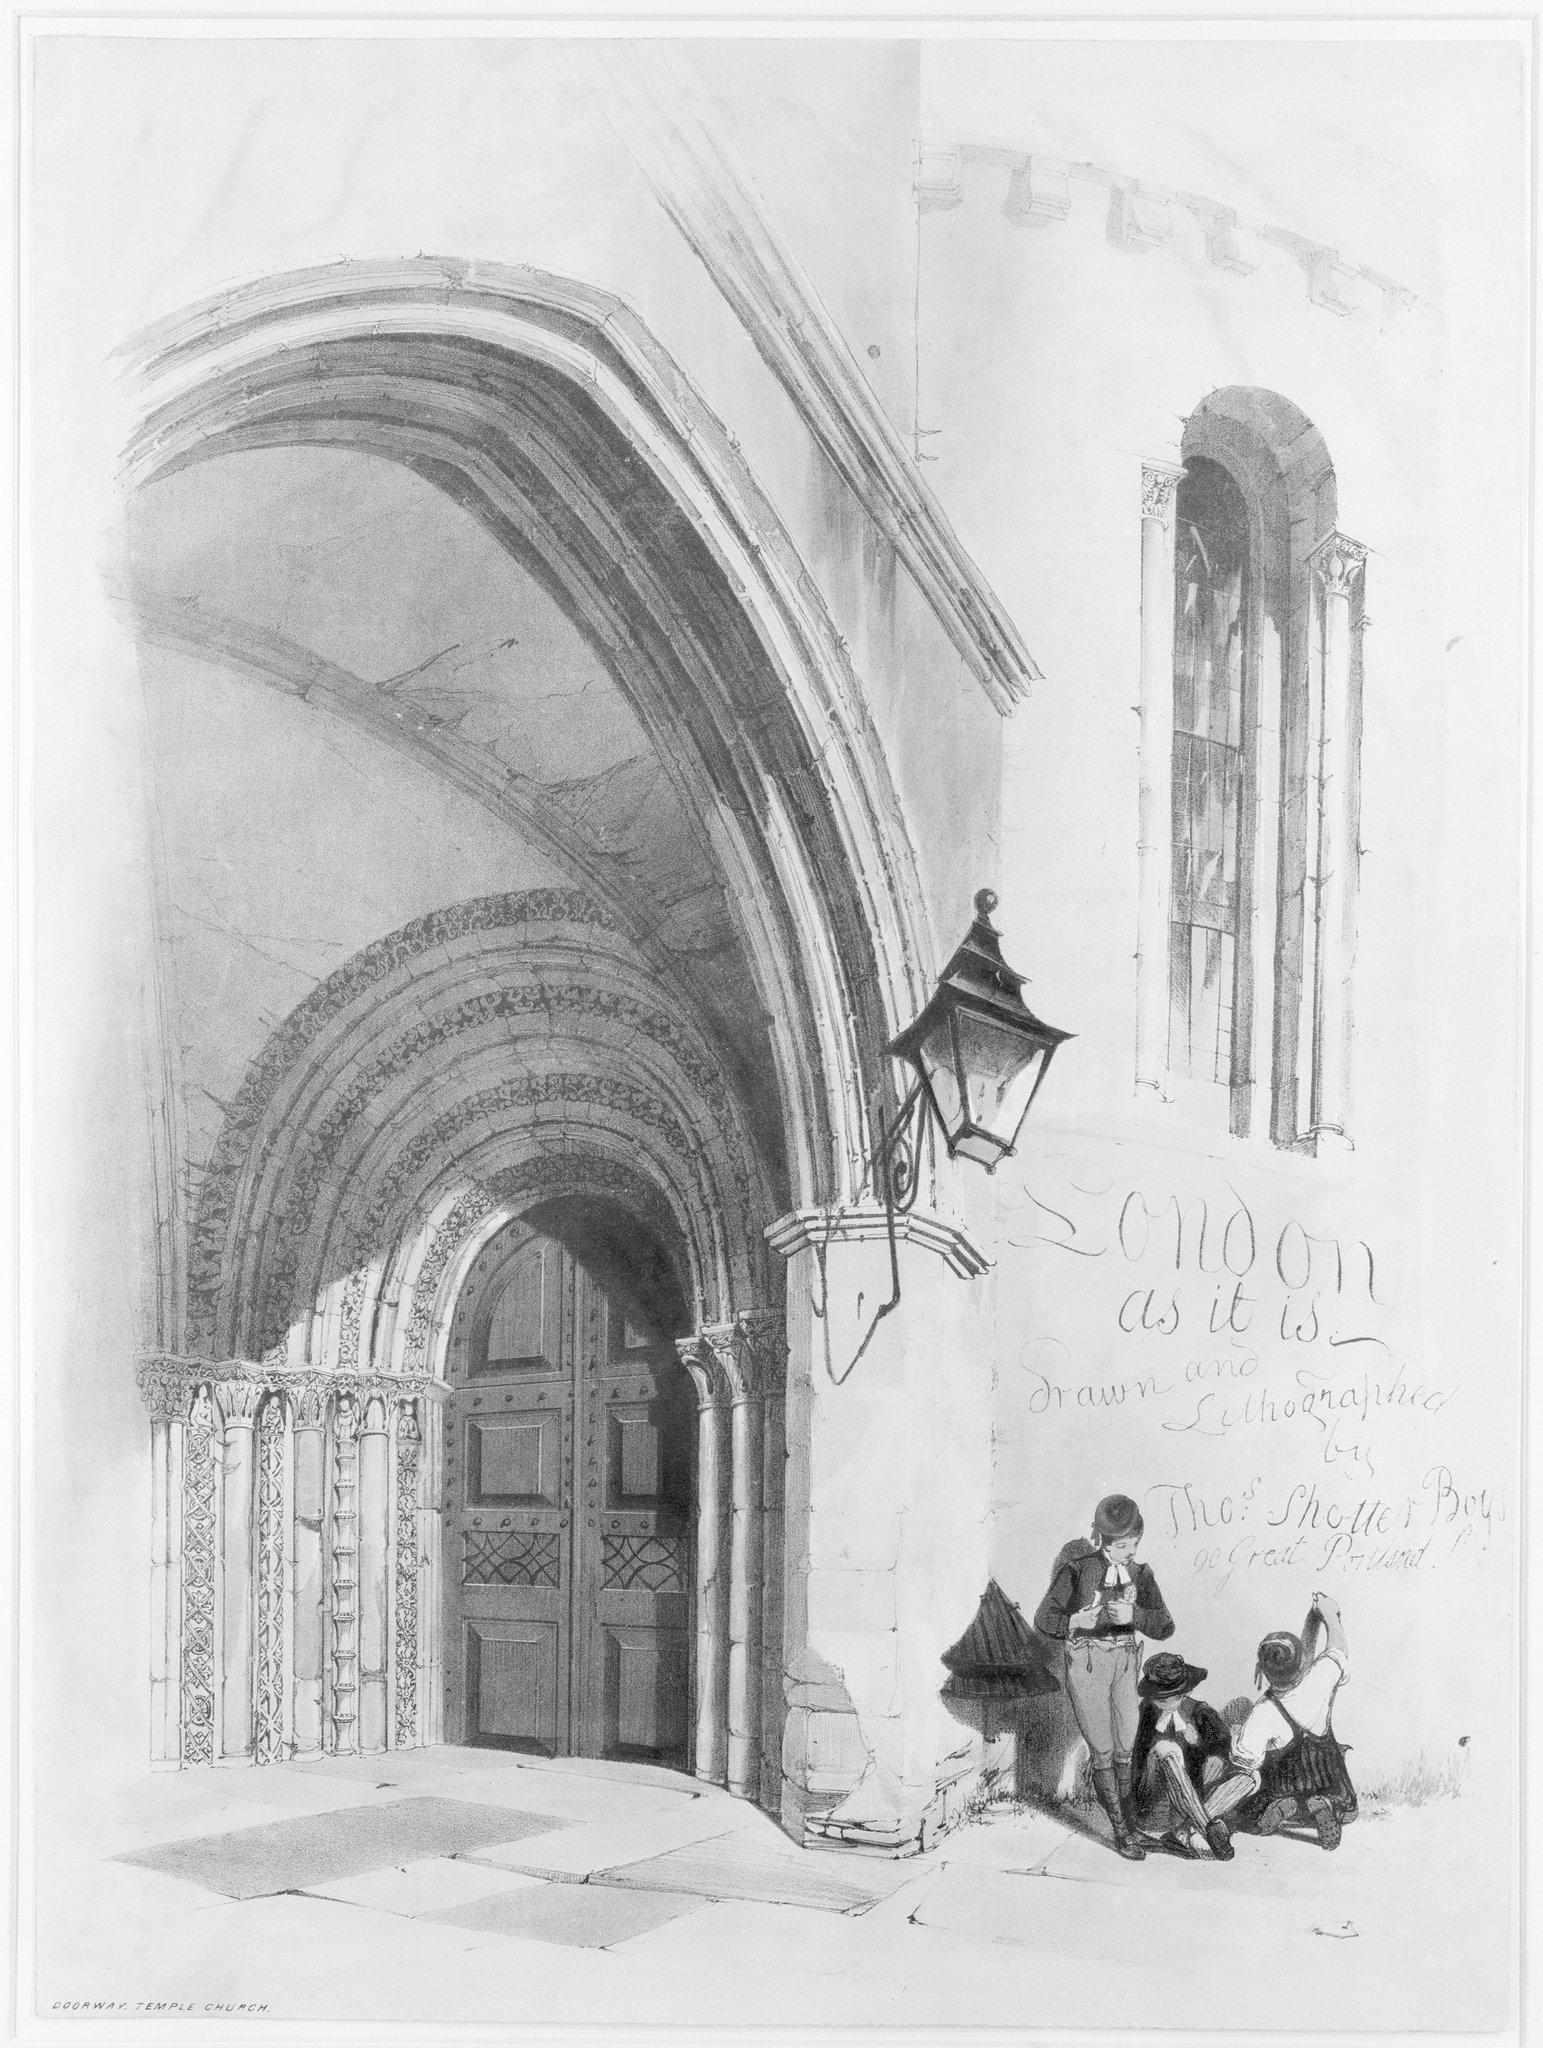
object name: print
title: Doorway, Temple Church (Frontispiece)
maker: thomas shotter boys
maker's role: artist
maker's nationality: british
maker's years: 1803-1874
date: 1842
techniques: hand coloring, lithograph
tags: doors